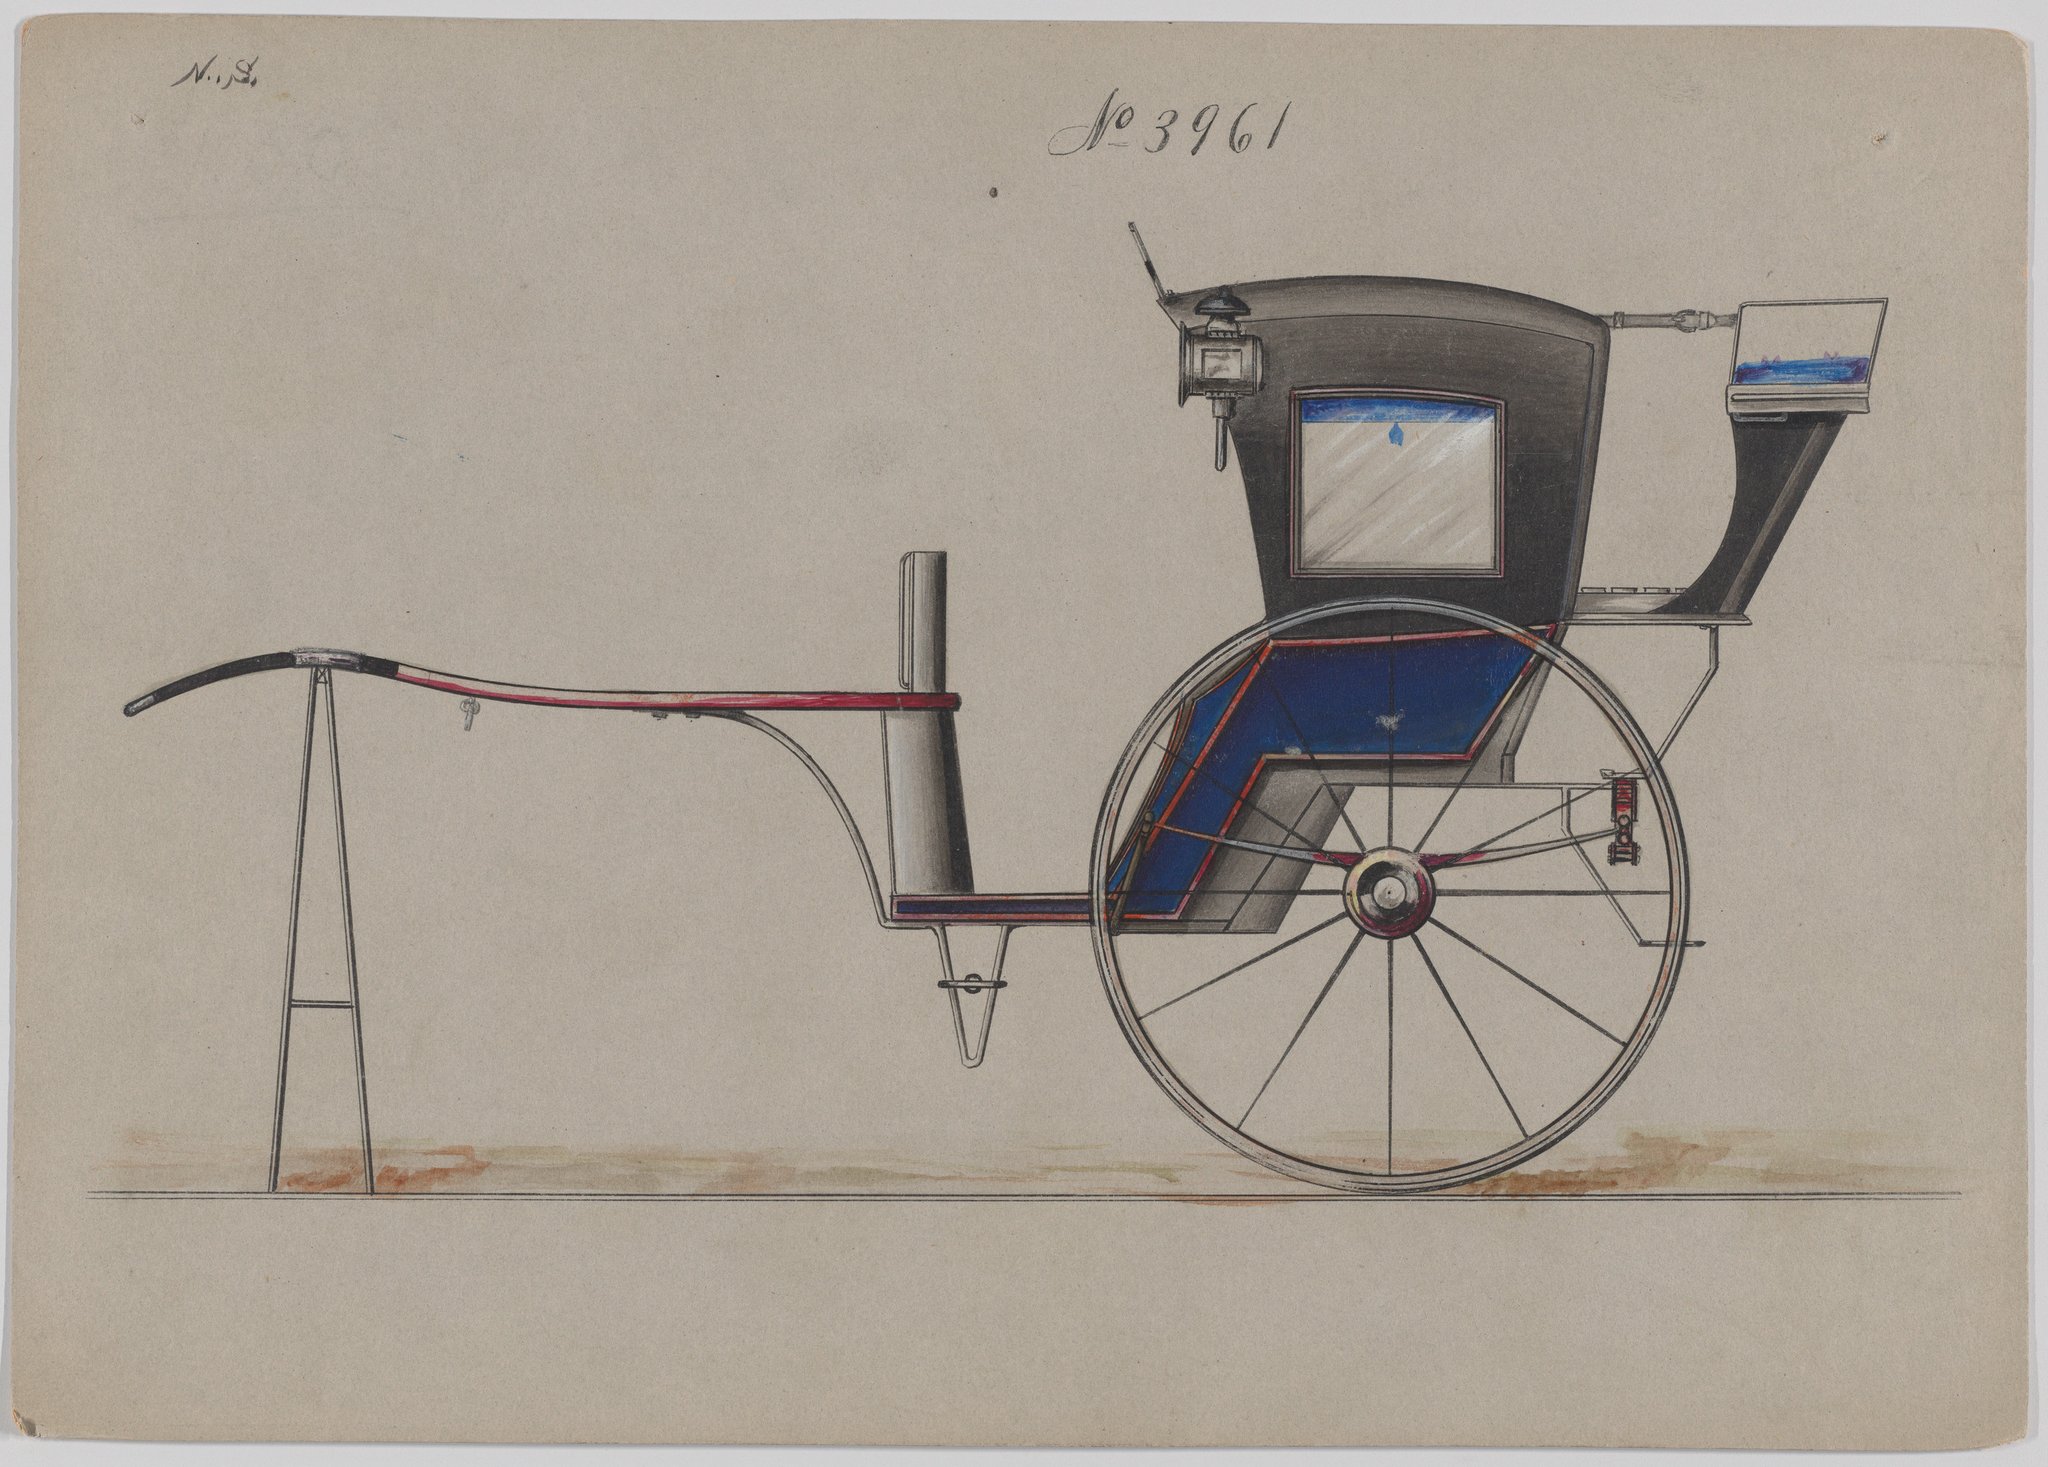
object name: drawing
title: Design for a Hansom or Forder Cab, no. 3961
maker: brewster & co.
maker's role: manufacturer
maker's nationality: american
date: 1886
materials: gouache, gum arabic, ink, watercolor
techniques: pen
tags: carriages